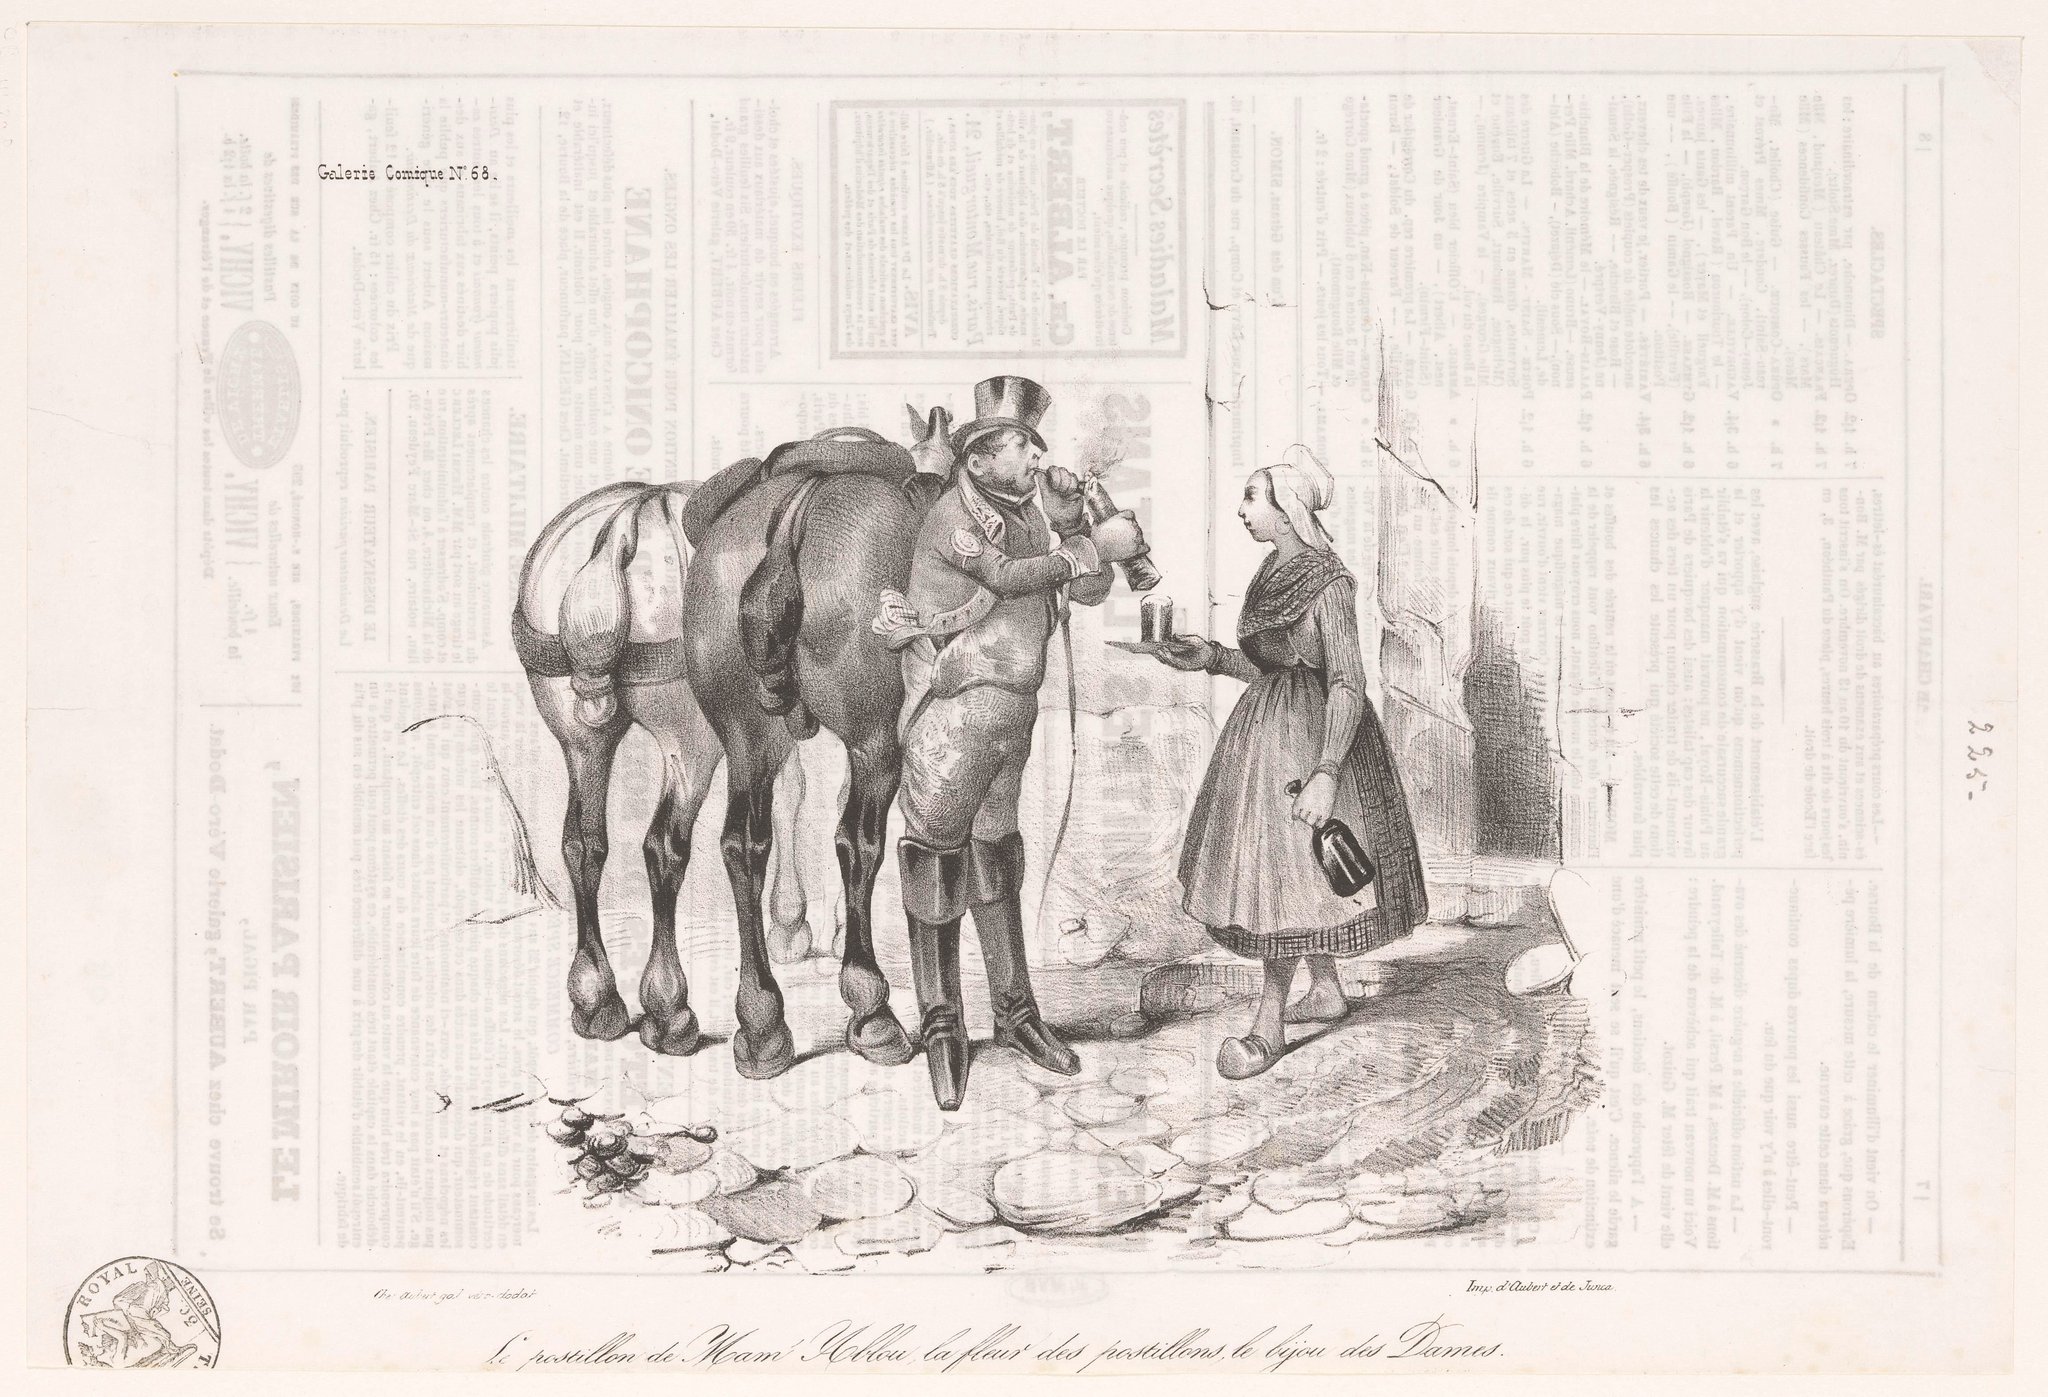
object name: cartoon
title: Komische gebeurtenissen uit het alledaagse leven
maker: victor adam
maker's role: painter, print maker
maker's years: 1801-1866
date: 1837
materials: paper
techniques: letterpress printing, lithograph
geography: paris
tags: postman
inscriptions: annotation: ‘225’, collector's mark: Lugt 2228, stamp: ‘Timbre Royal Seine 3 c.’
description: Prent uit: Le Charivari 6 (1837), nr. 287, 14 oktober 1837. De postiljon was een koerier die te voet of te paard post overbracht. 'Le Postillon de Mam'Ablon' was een toneelstuk dat in 1846 werd opgevoerd in Parijs.